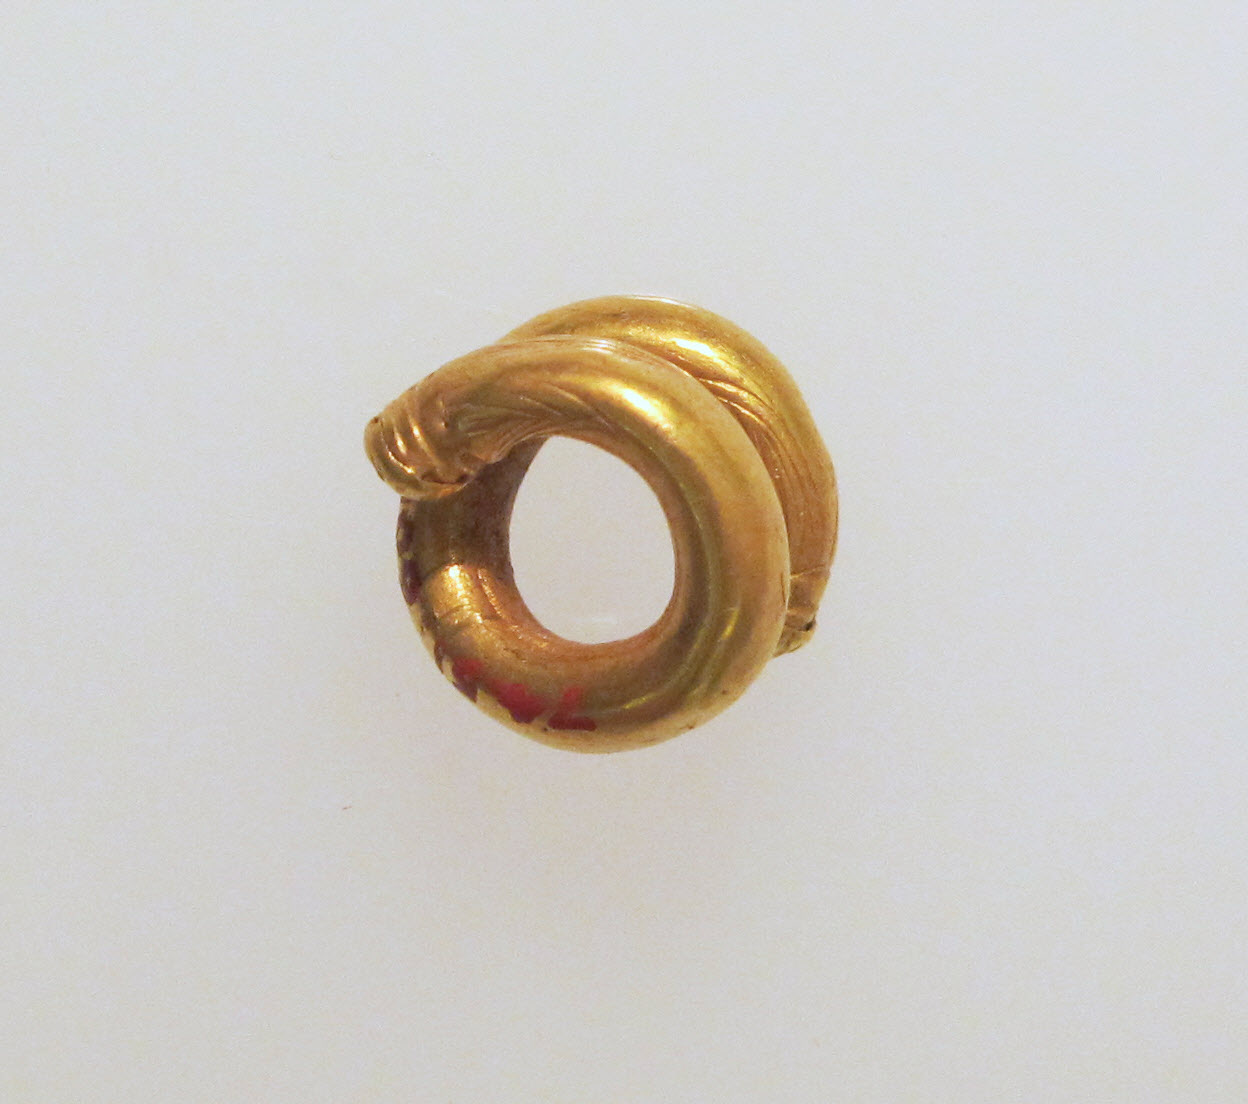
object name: earring or spiral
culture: cypriot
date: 500-401 BCE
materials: bronze, gold